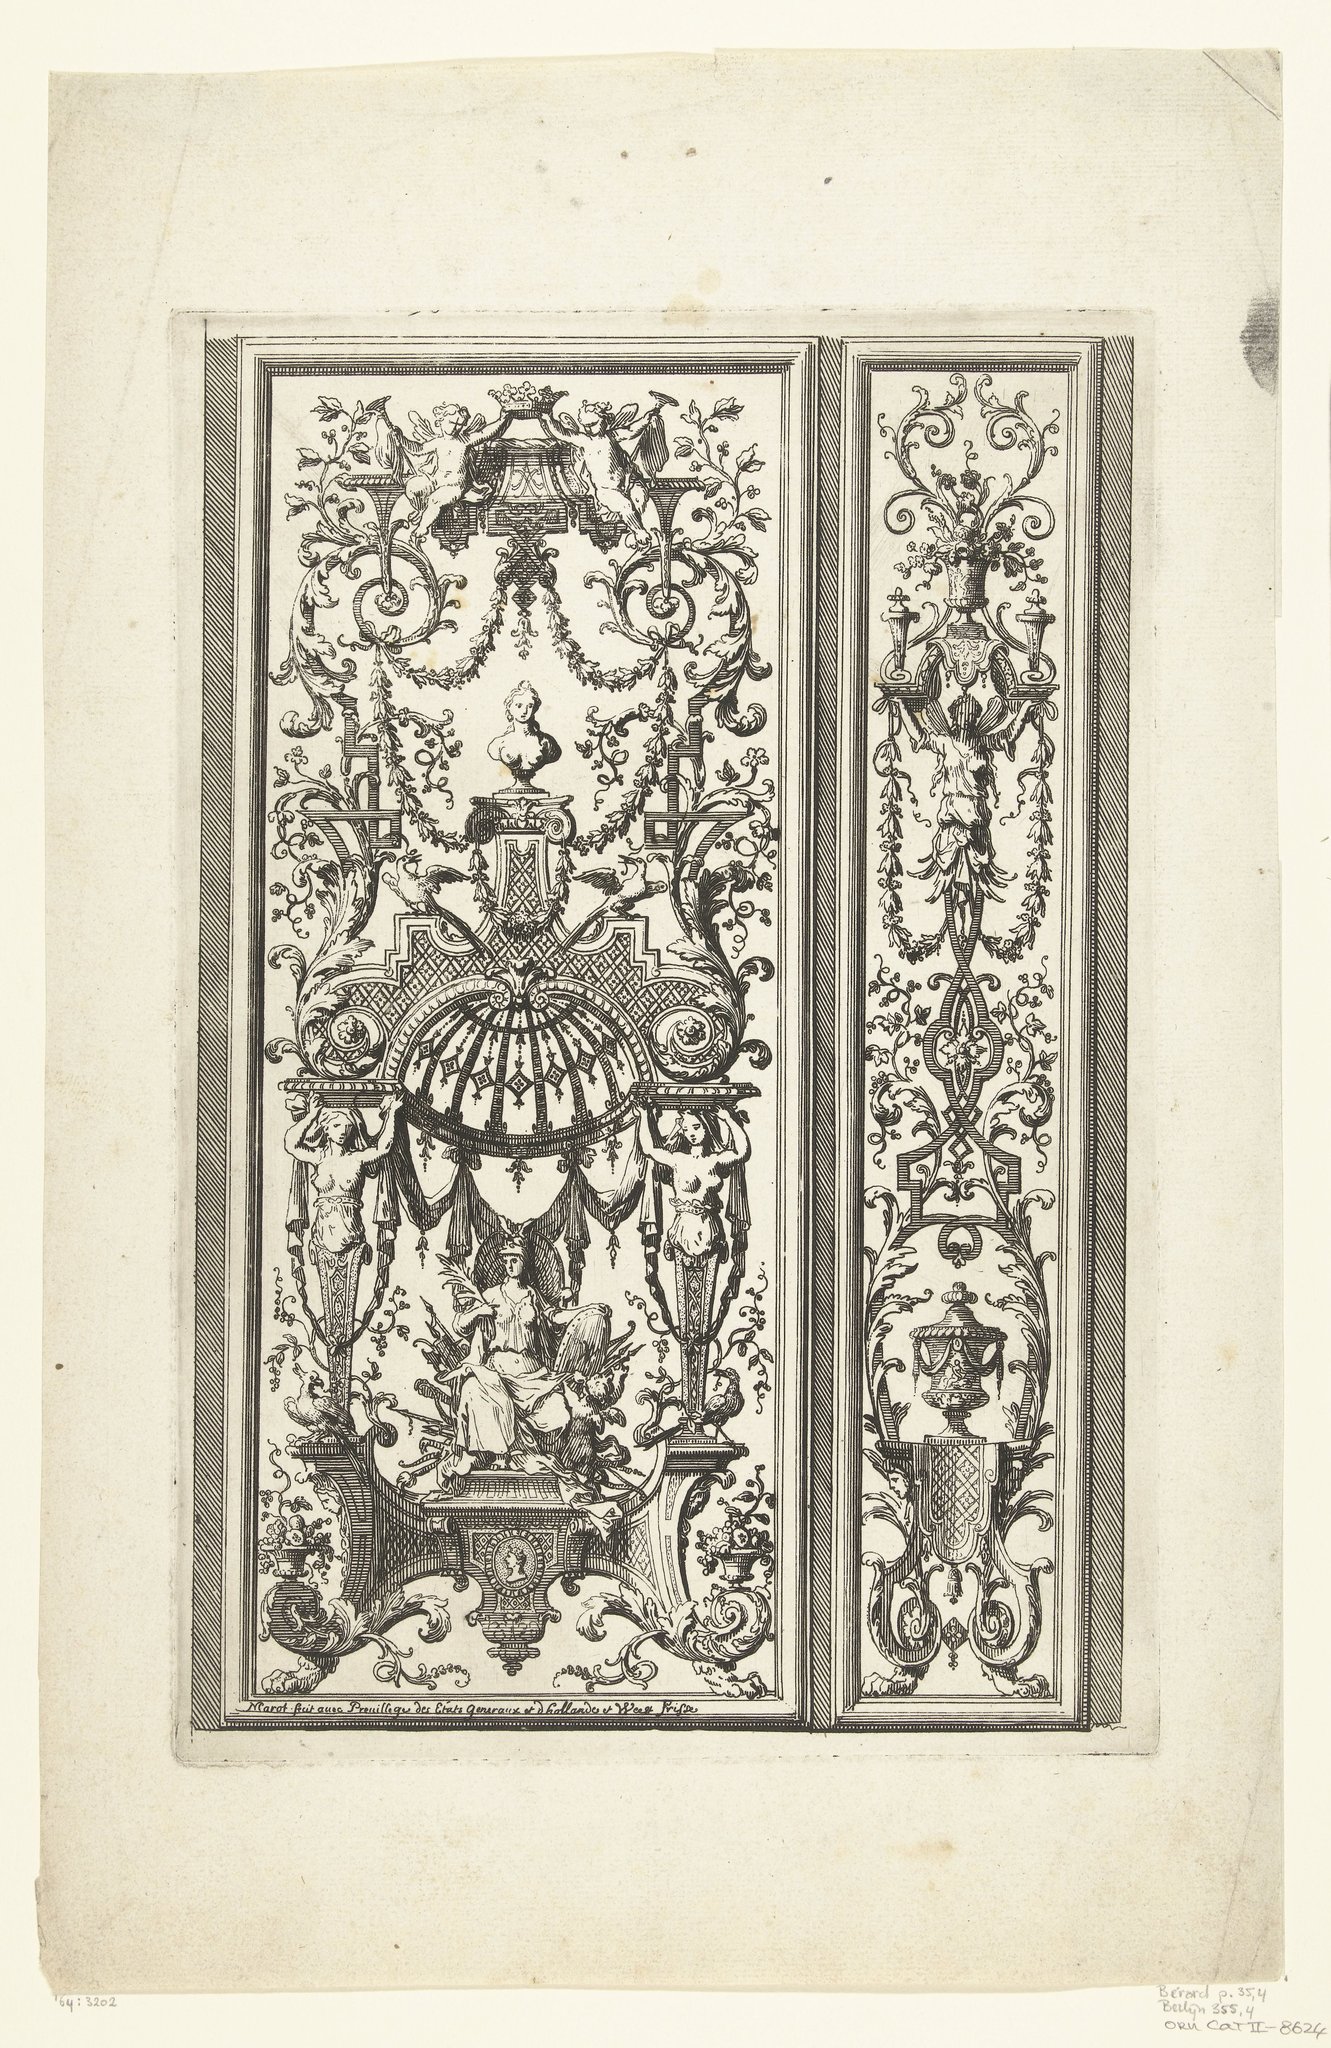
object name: ornament print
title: Second Liure d'Ornements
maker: daniël marot (i)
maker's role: draughtsman, print maker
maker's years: 1661-1752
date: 1712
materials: paper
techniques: etching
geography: amsterdam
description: Op het paneel links zit Minerva op een troon bestaande uit een wapentrofee met een schild waarop de initialen van William III staan. Op het paneel rechts staat onderaan een vaas op een voetstuk. Uit serie van 6 bladen.